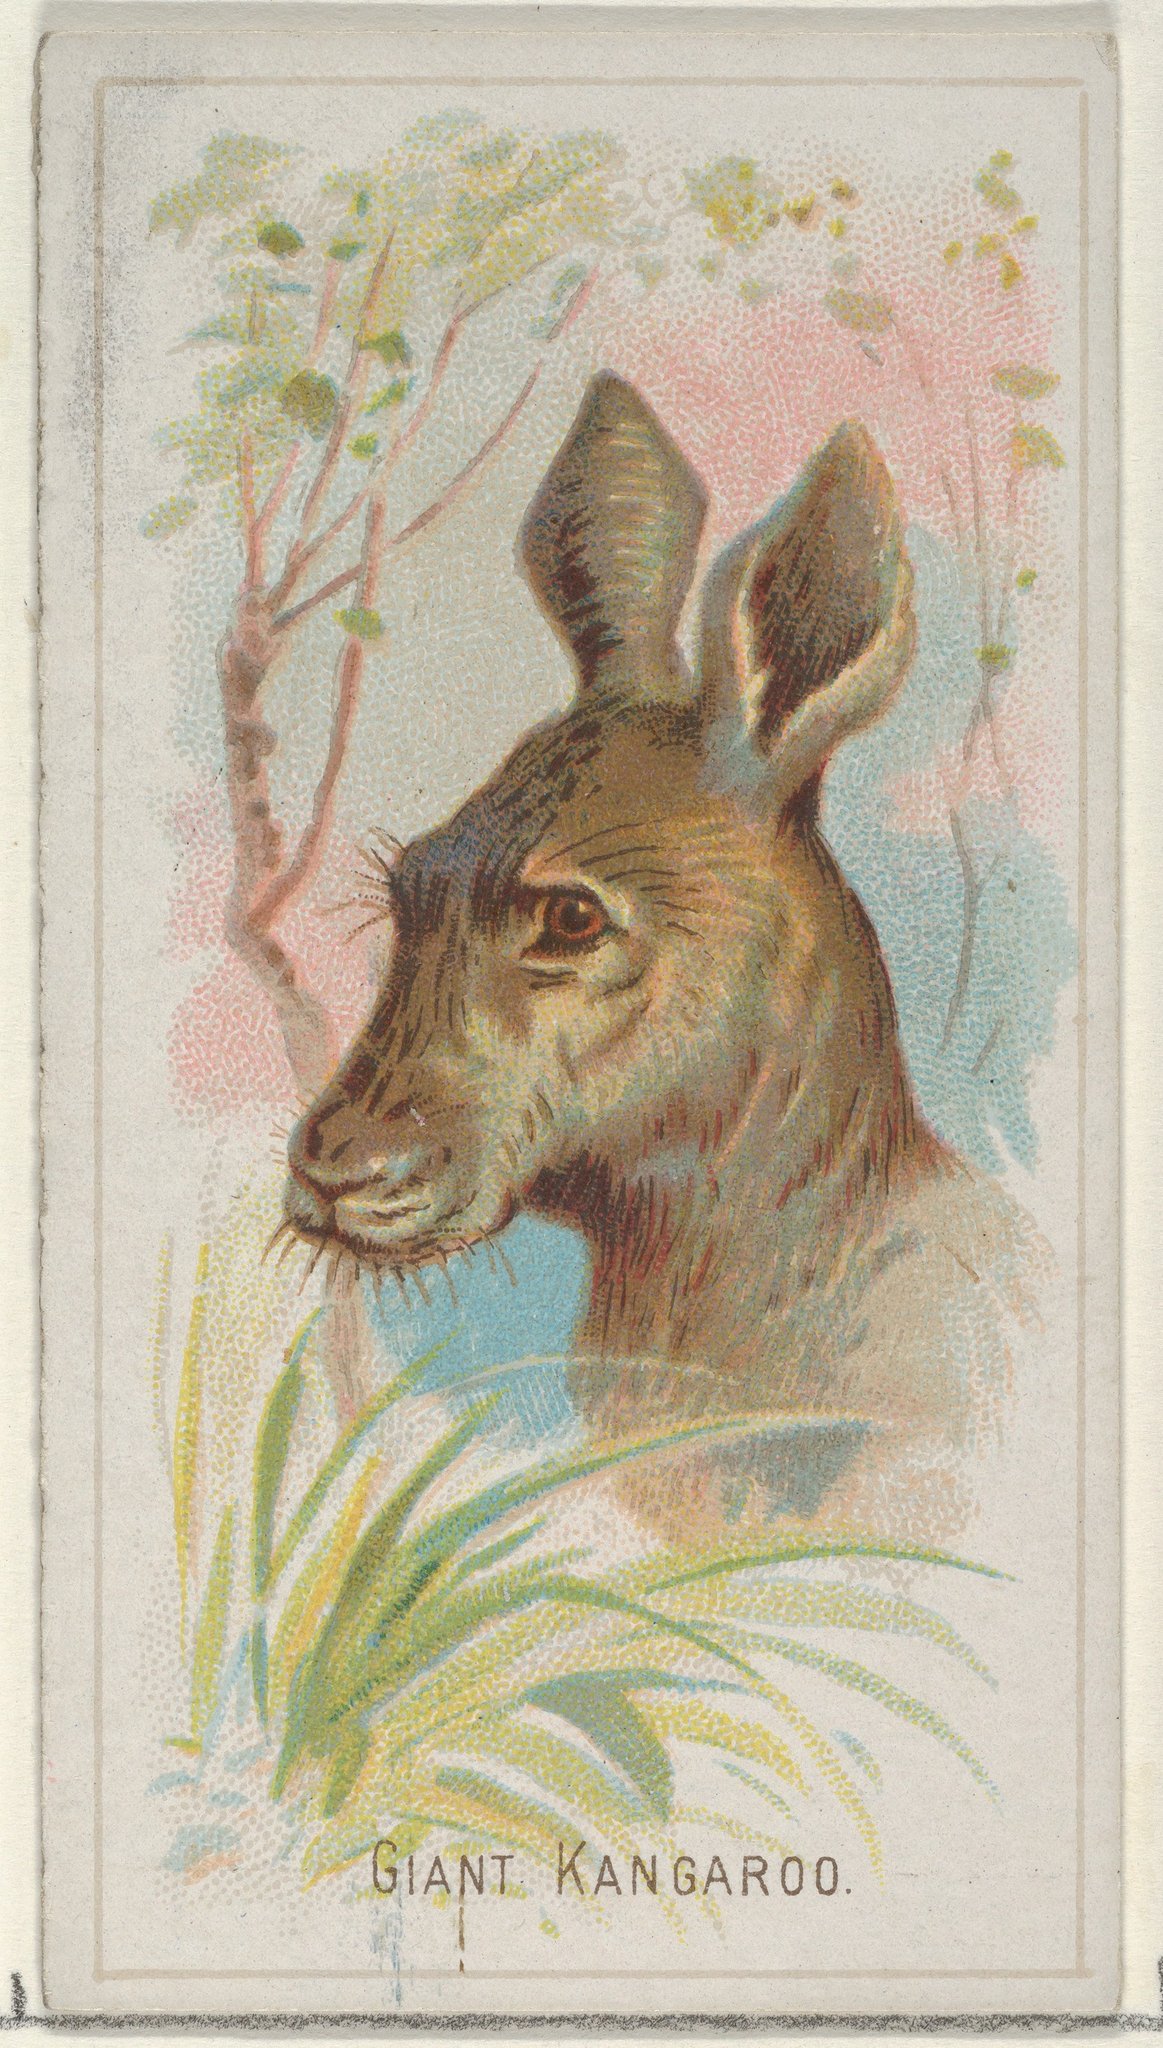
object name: print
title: Giant Kangaroo, from the Wild Animals of the World series (N25) for Allen & Ginter Cigarettes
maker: allen & ginter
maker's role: publisher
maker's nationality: american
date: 1888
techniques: color lithograph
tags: animals